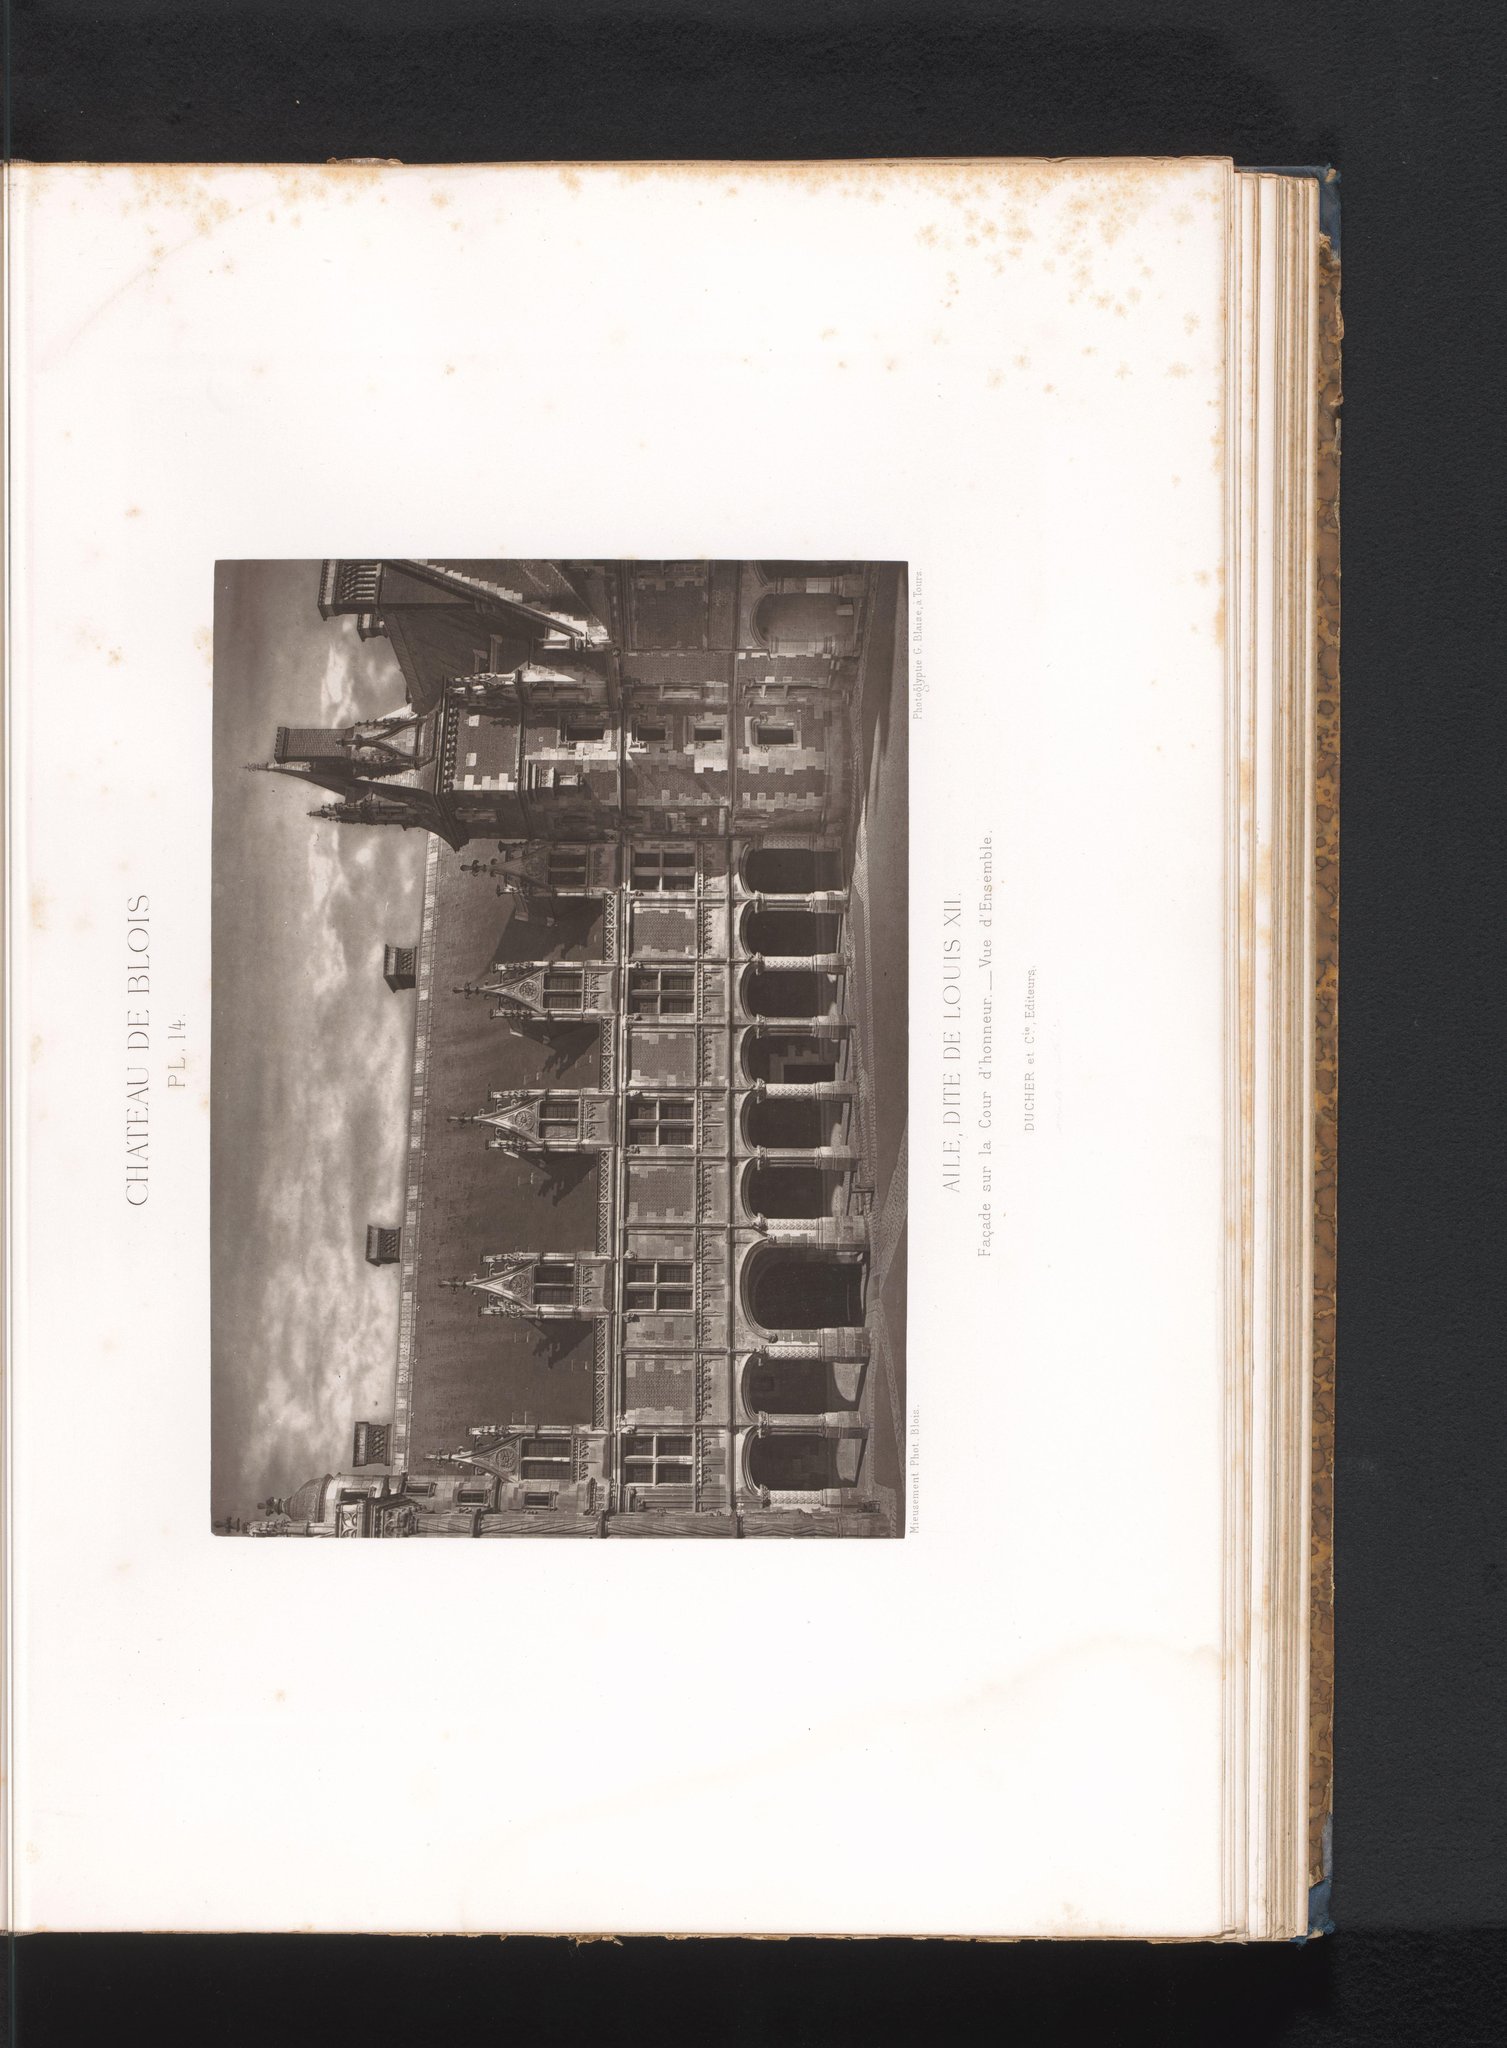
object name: page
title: Gezicht op de Lodewijk XII vleugel van het Kasteel van Blois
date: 1870-1875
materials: paper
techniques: woodburytype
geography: tours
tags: castle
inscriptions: number: ‘PL. 14.’